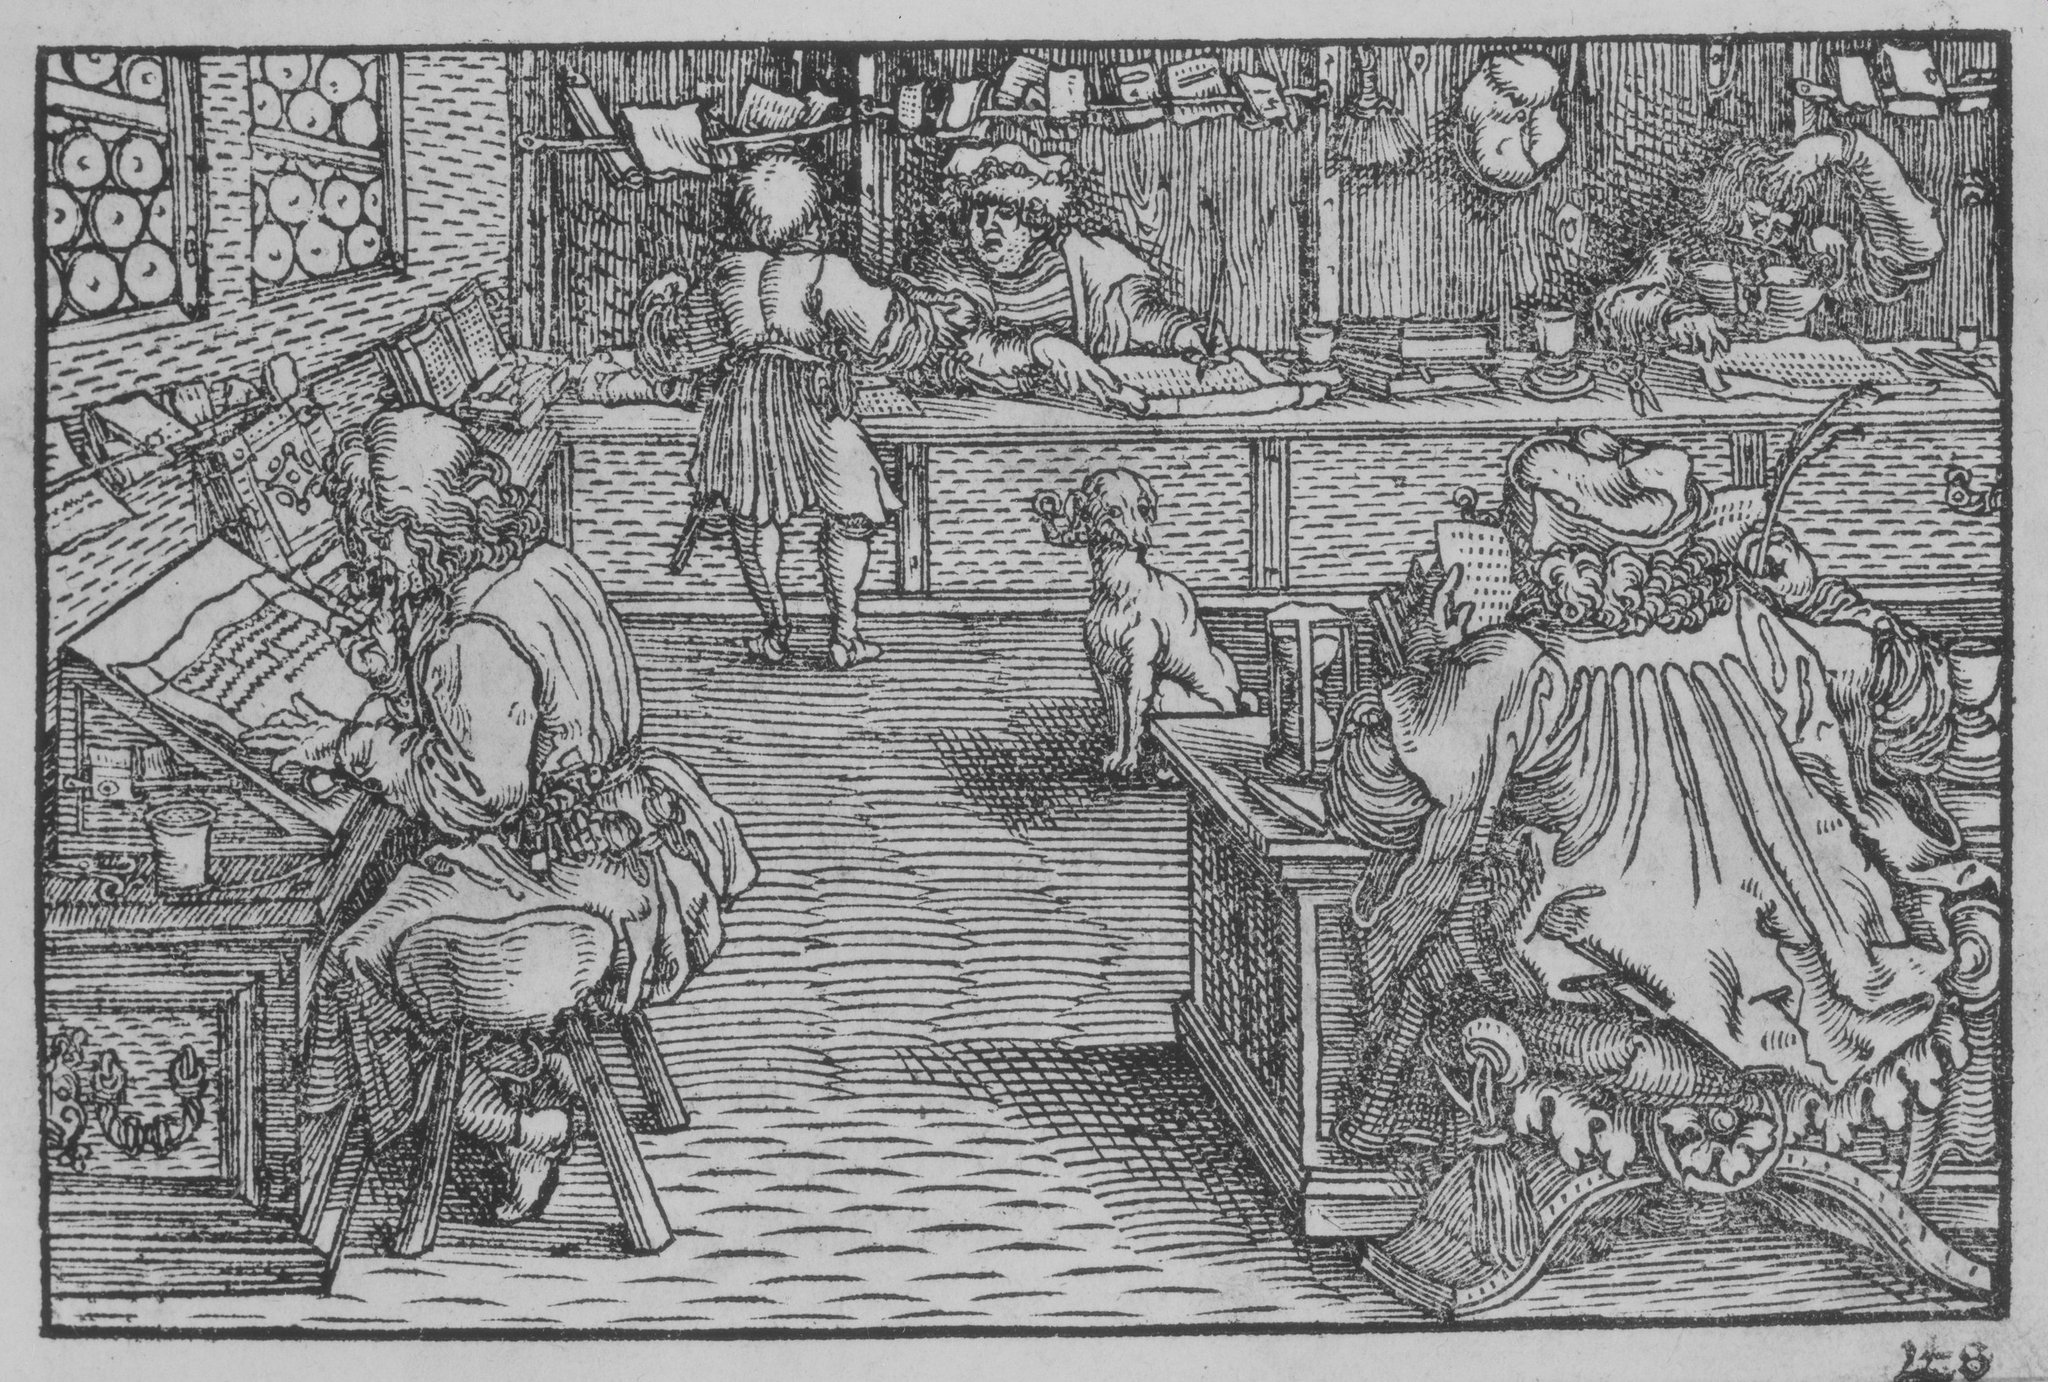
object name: book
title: Officia M.T.C. Von den tugentsamen ämptern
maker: marcus tullius cicero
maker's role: author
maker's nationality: roman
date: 1531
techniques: woodcut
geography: germany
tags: men,dogs,working,writing